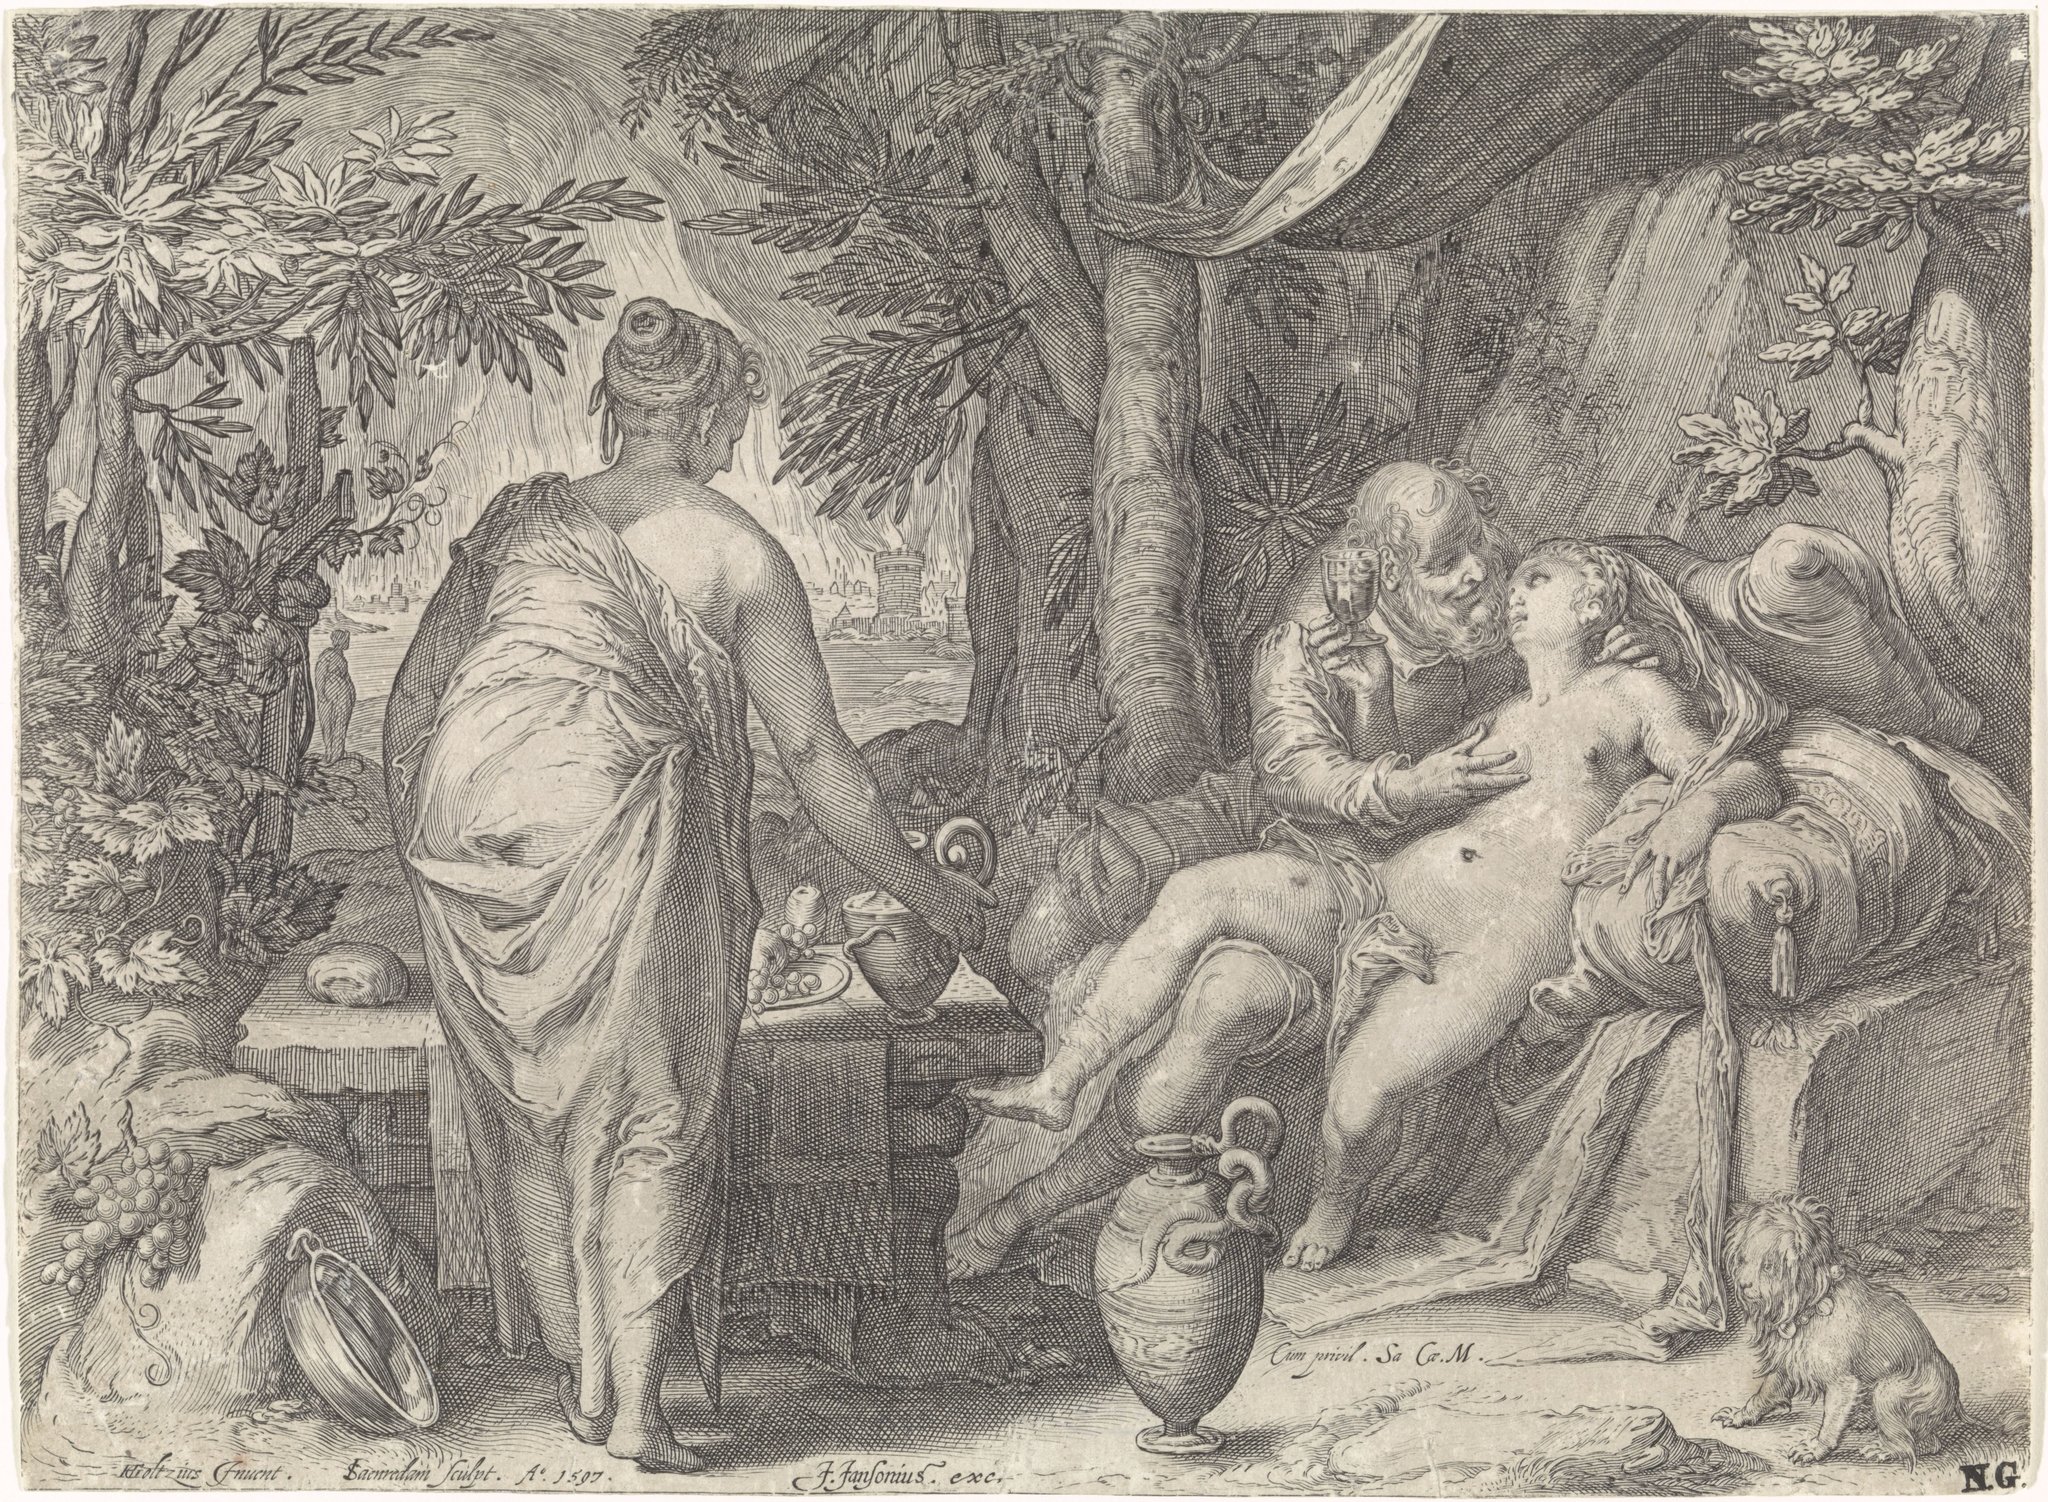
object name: print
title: Lot en zijn dochters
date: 1597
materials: paper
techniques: engraving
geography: haarlem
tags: sodom and gomorrah burning, lot's wife looks back at the city and is transformed into a pillar of salt, lot's daughters make their father drunk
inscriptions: collector's mark: Lugt 1967, collector's mark: Lugt 2228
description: De dronken Lot zit op een rots en kust een van zijn dochters. Zij houdt een wijnglas in de hand en omarmt haar vader. De andere dochter staat op de voorgrond met een kruik in de hand. Beide dochters verleiden hun vader Lot en voeren hem dronken, zodat ze zijn kinderen kunnen dragen (Gen. 18: 31-34). In de achtergrond: het brandend Sodom en Lots vrouw als zoutpilaar (Gen. 18: 24-26).